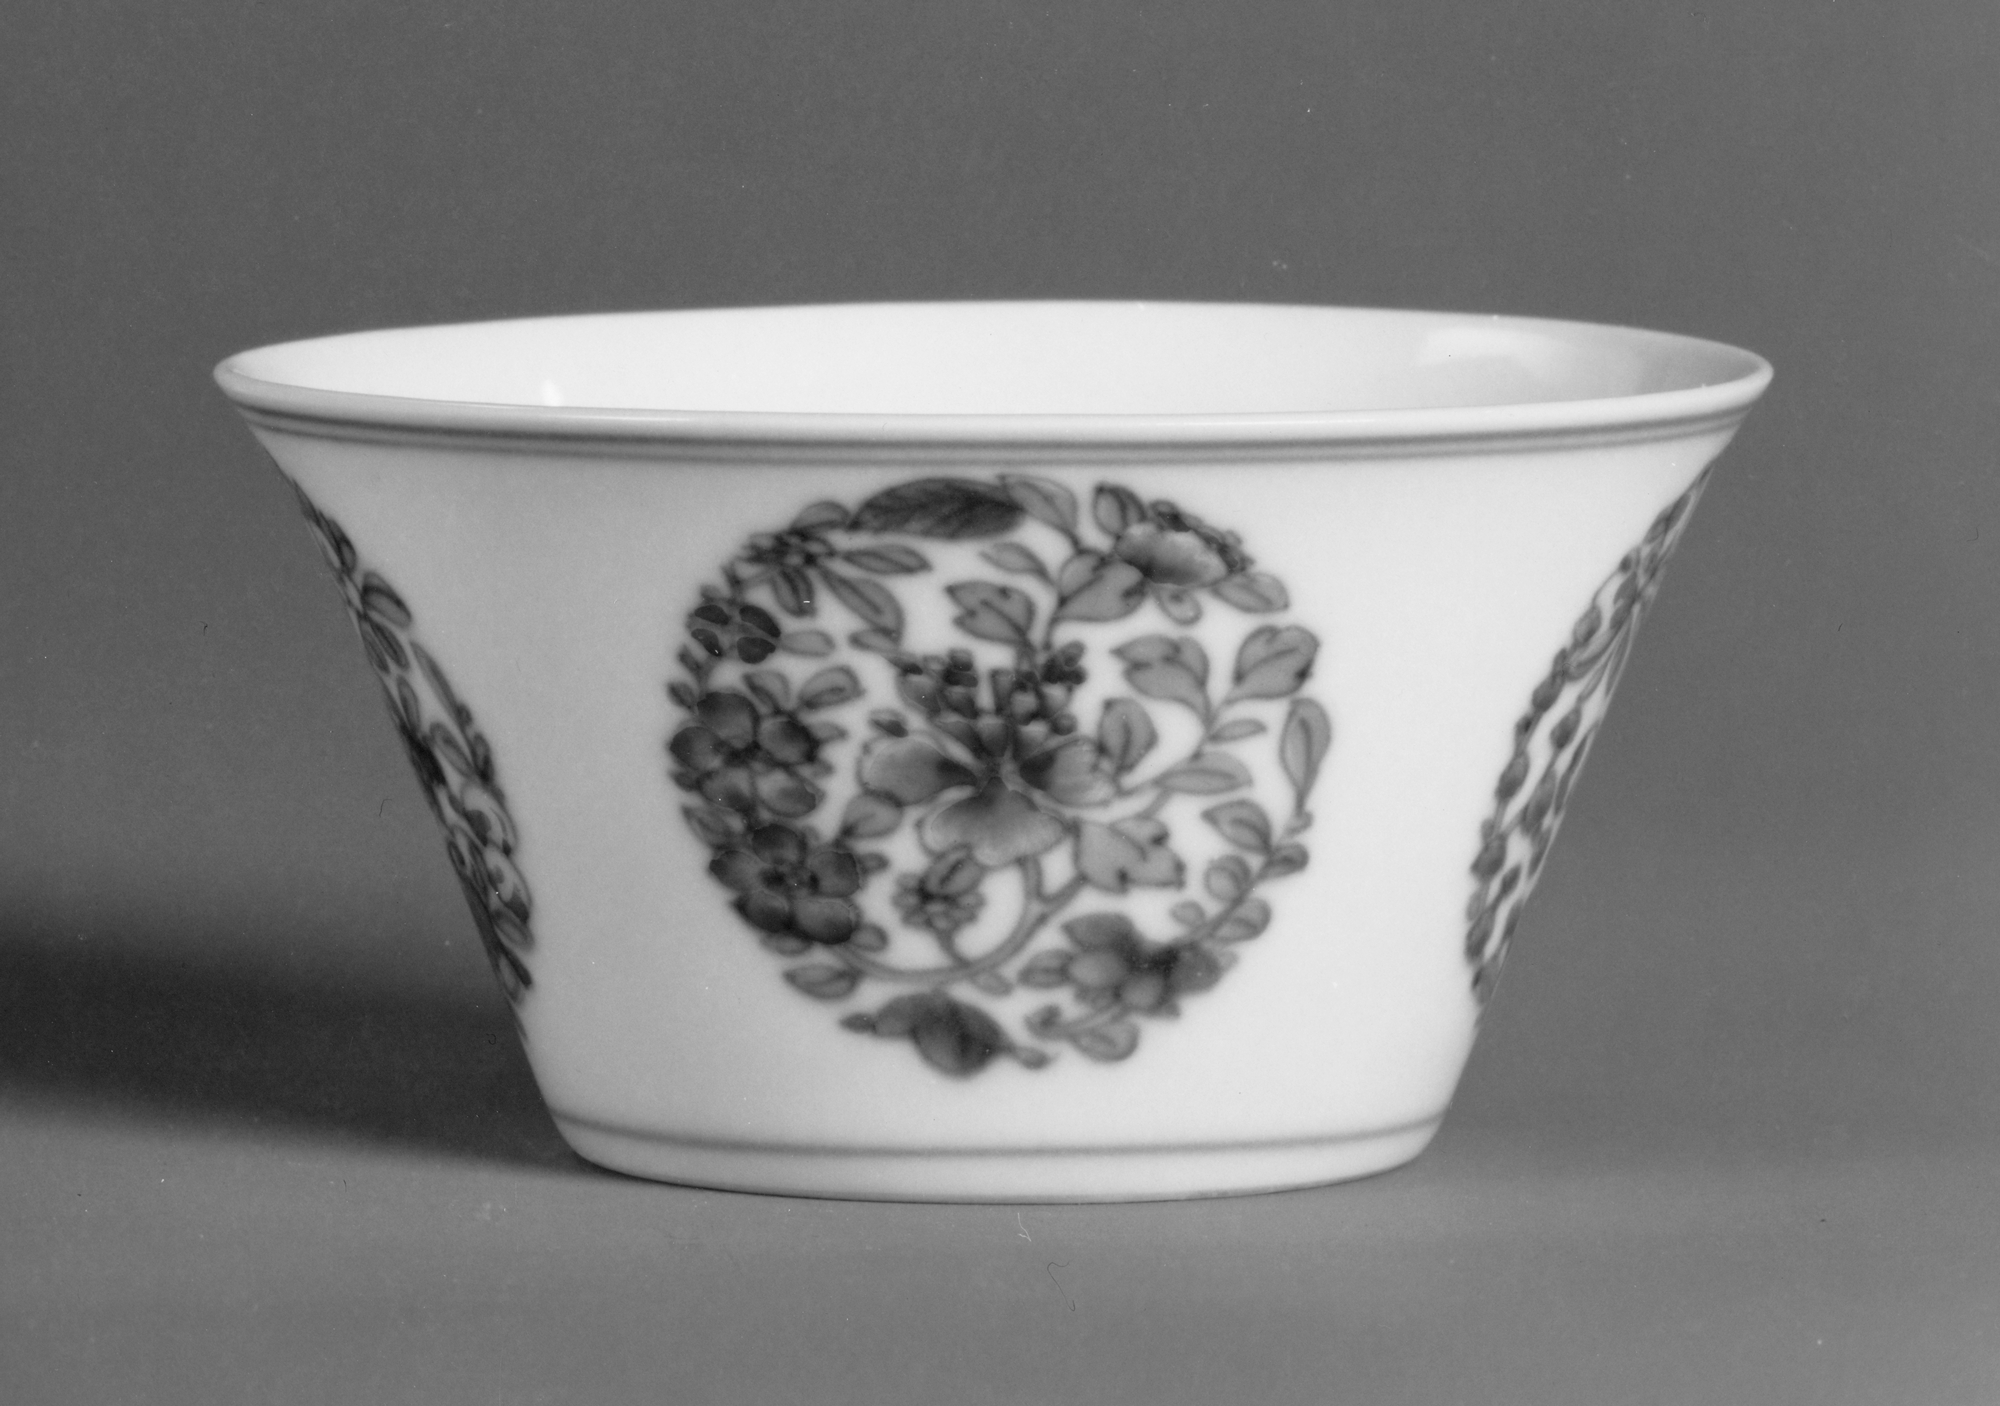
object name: cup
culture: chinese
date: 1701-1800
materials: enamel, porcelain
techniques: overglaze, painting, underglaze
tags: flowers,leaves